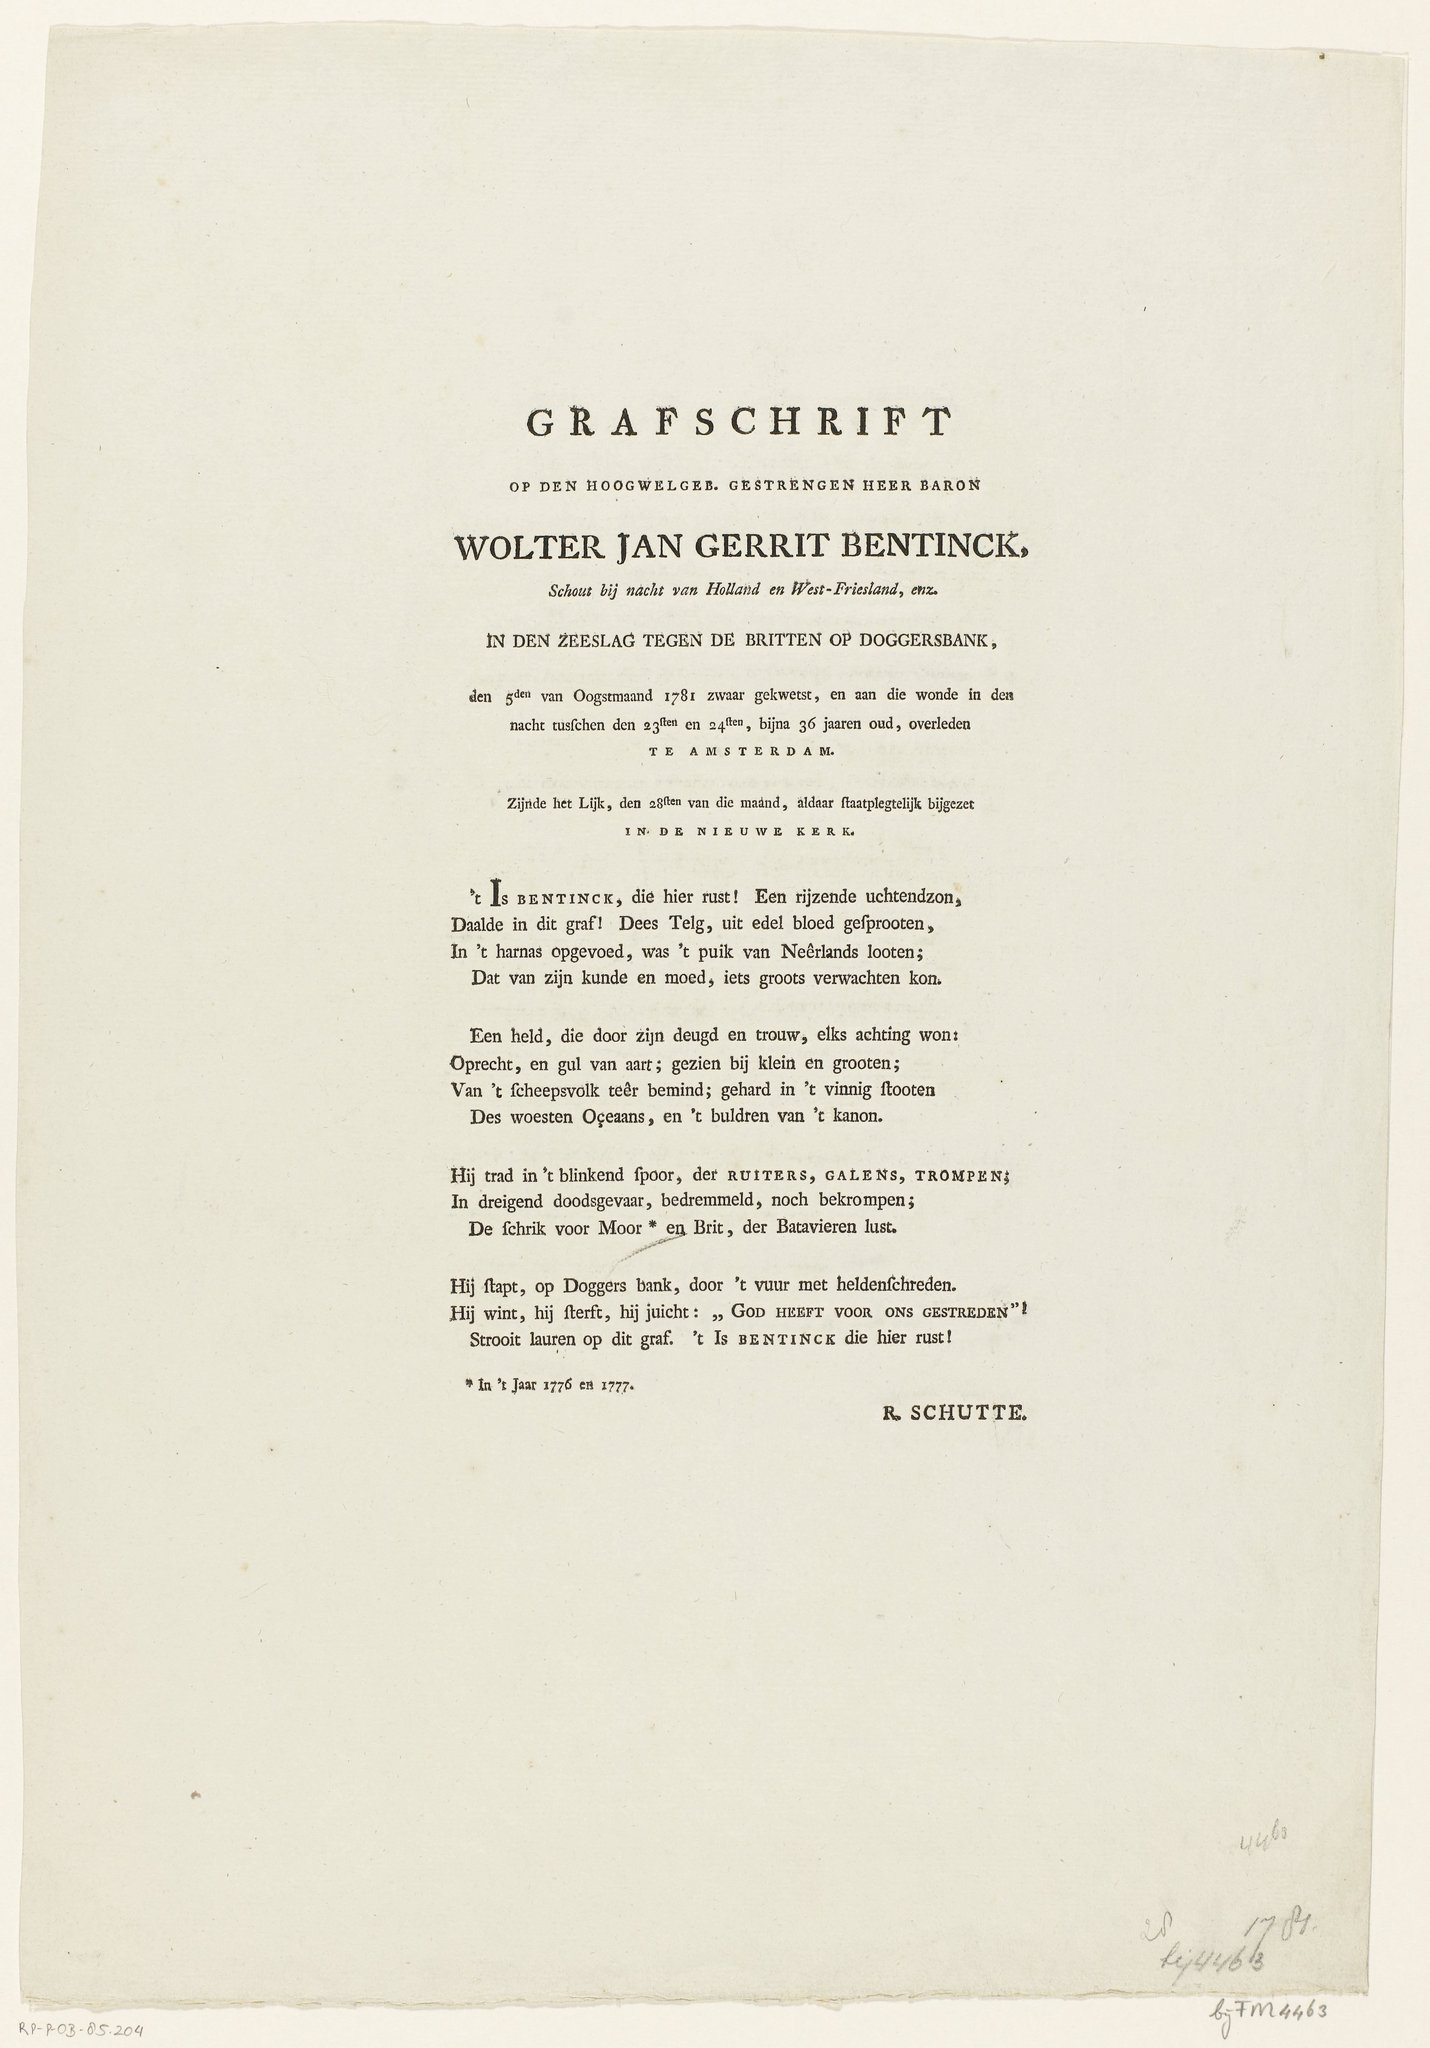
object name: text sheet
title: Grafschrift bij het overlijden van Wolter Jan Gerrit baron Bentinck, 1781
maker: rutger schutte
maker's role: schrijver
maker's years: 1706-1784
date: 1781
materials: paper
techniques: letterpress printing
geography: northern netherlands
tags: raalte, schout-bij-nacht, wolter jan gerrit bentinck, nieuwe kerk, zeeslag bij doggersbank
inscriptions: collector's mark: Lugt 2228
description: Grafschrift op het overlijden van Wolter Jan Gerrit baron Bentinck op 23/24 augustus aan zijn verwondingen opgelopen in de zeeslag bij Doggersbank en zijn begrafenis in de Nieuwe Kerk te Amsterdam op 28 augustus 1781. Titel met veertienregelig vers.